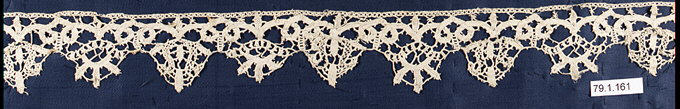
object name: strip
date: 1601-1700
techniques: lace